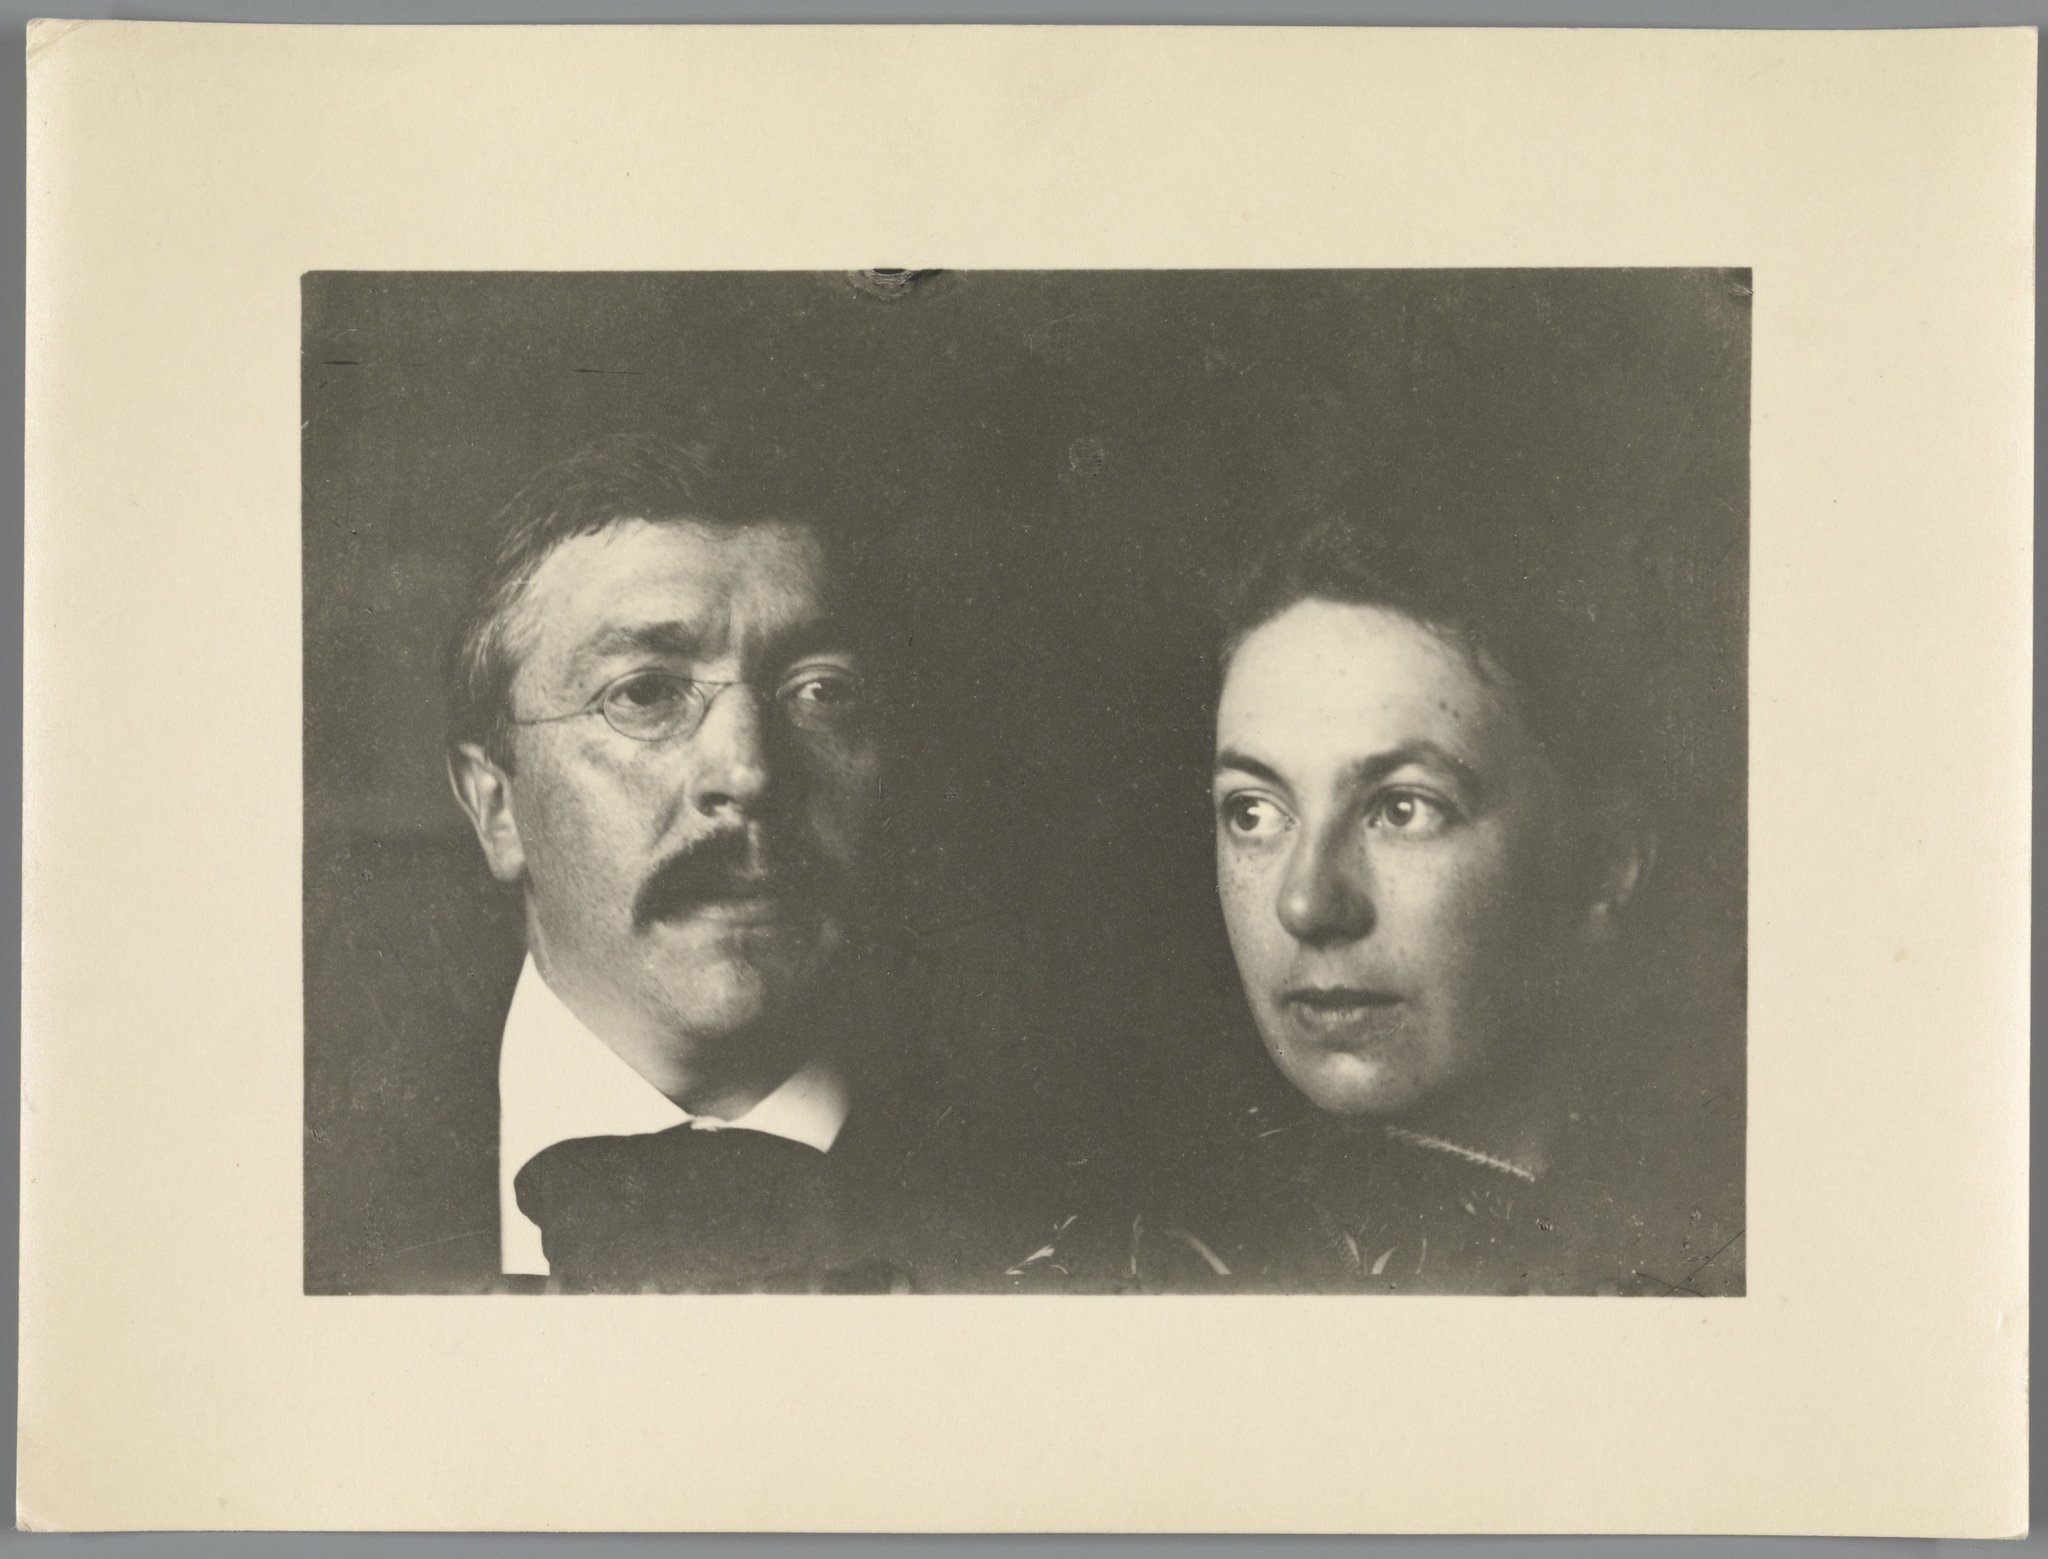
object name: photograph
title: Reproductie naar een foto van Willem Witsen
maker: Anonymous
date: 1860-1915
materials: paper, photographic support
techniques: gelatin silver print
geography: netherlands